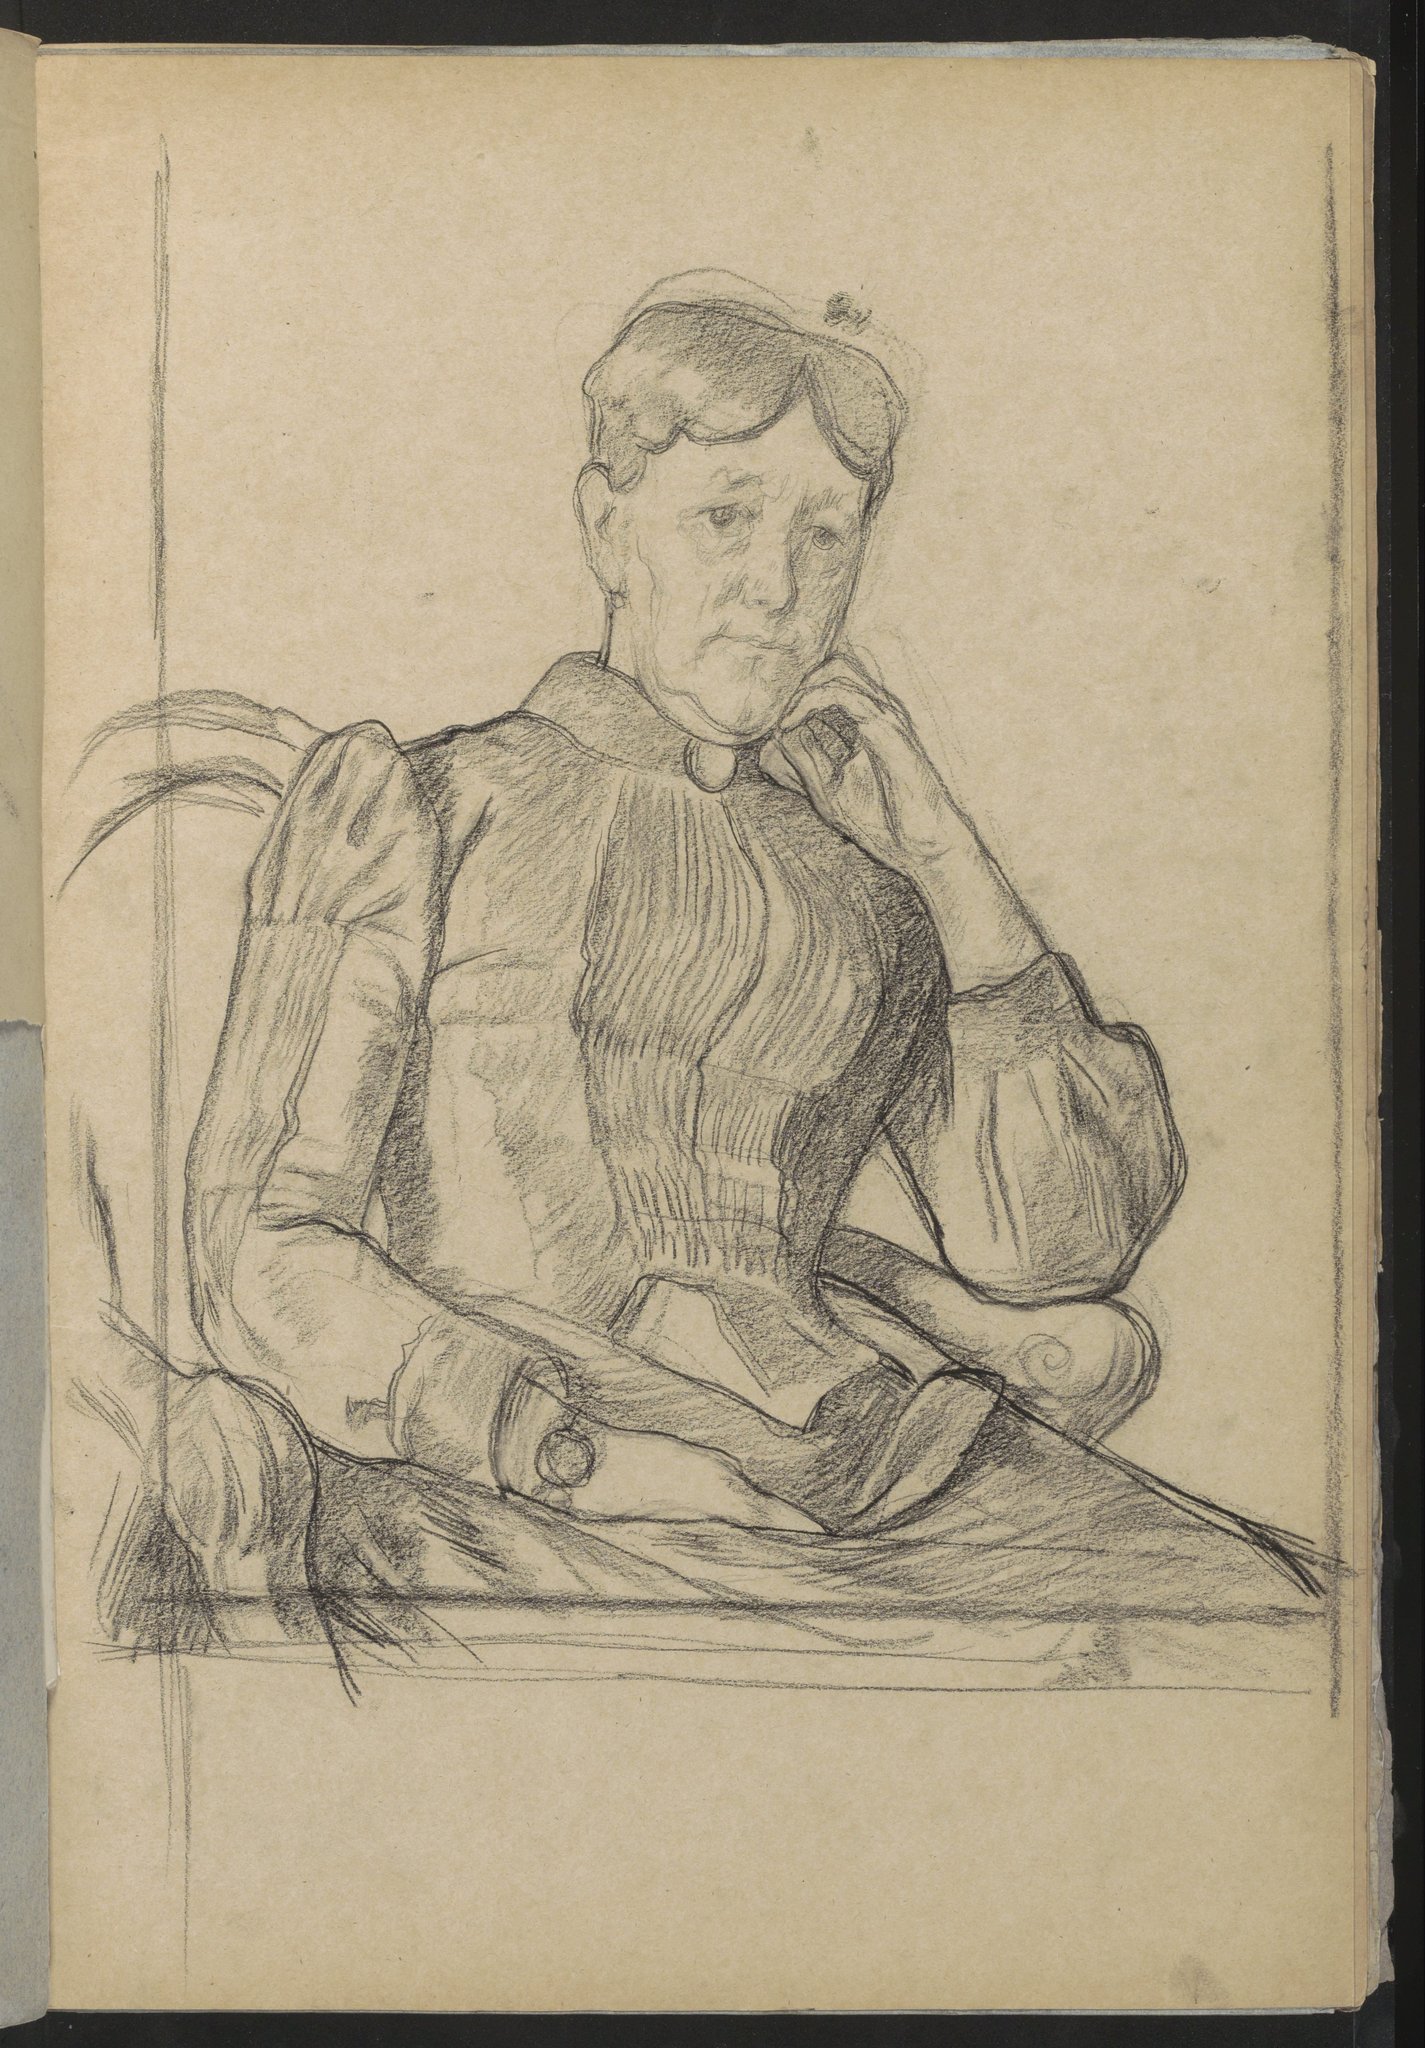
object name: sketchbook leaf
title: Portret van een zittende vrouw, de kin rustend op de linkerhand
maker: jan veth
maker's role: designer, draughtsman, painter, print maker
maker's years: 1864-1925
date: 1874-1925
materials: chalk, paper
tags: sitting figure, adult woman, hand(s) bent towards the head, chair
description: De studie is vrijwel identiek aan RP-T-1962-368-5-1, op de bredere uitsnede na, waardoor meer van het onderlijf van de vrouw te zien is.